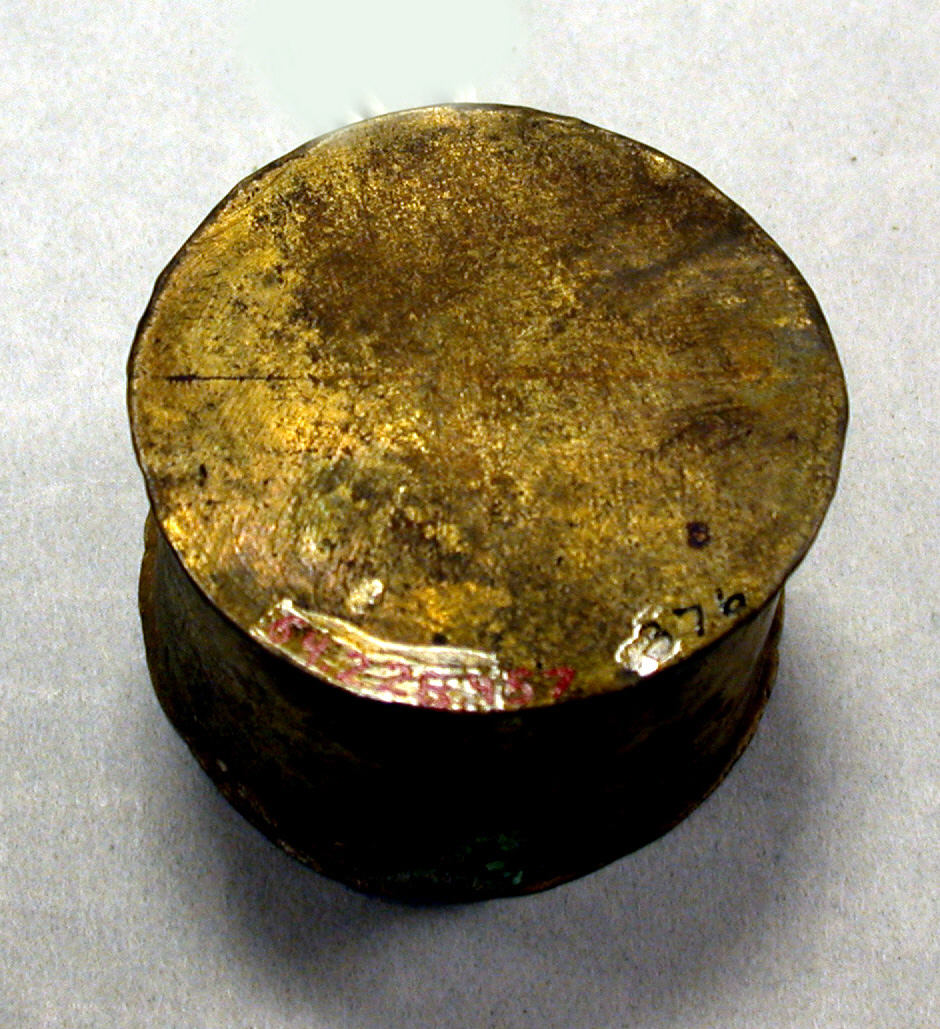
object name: drum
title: Hammered Silver Miniature Drum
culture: chancay or chimú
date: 1001-1466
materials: gilt, silver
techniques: hammering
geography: peru